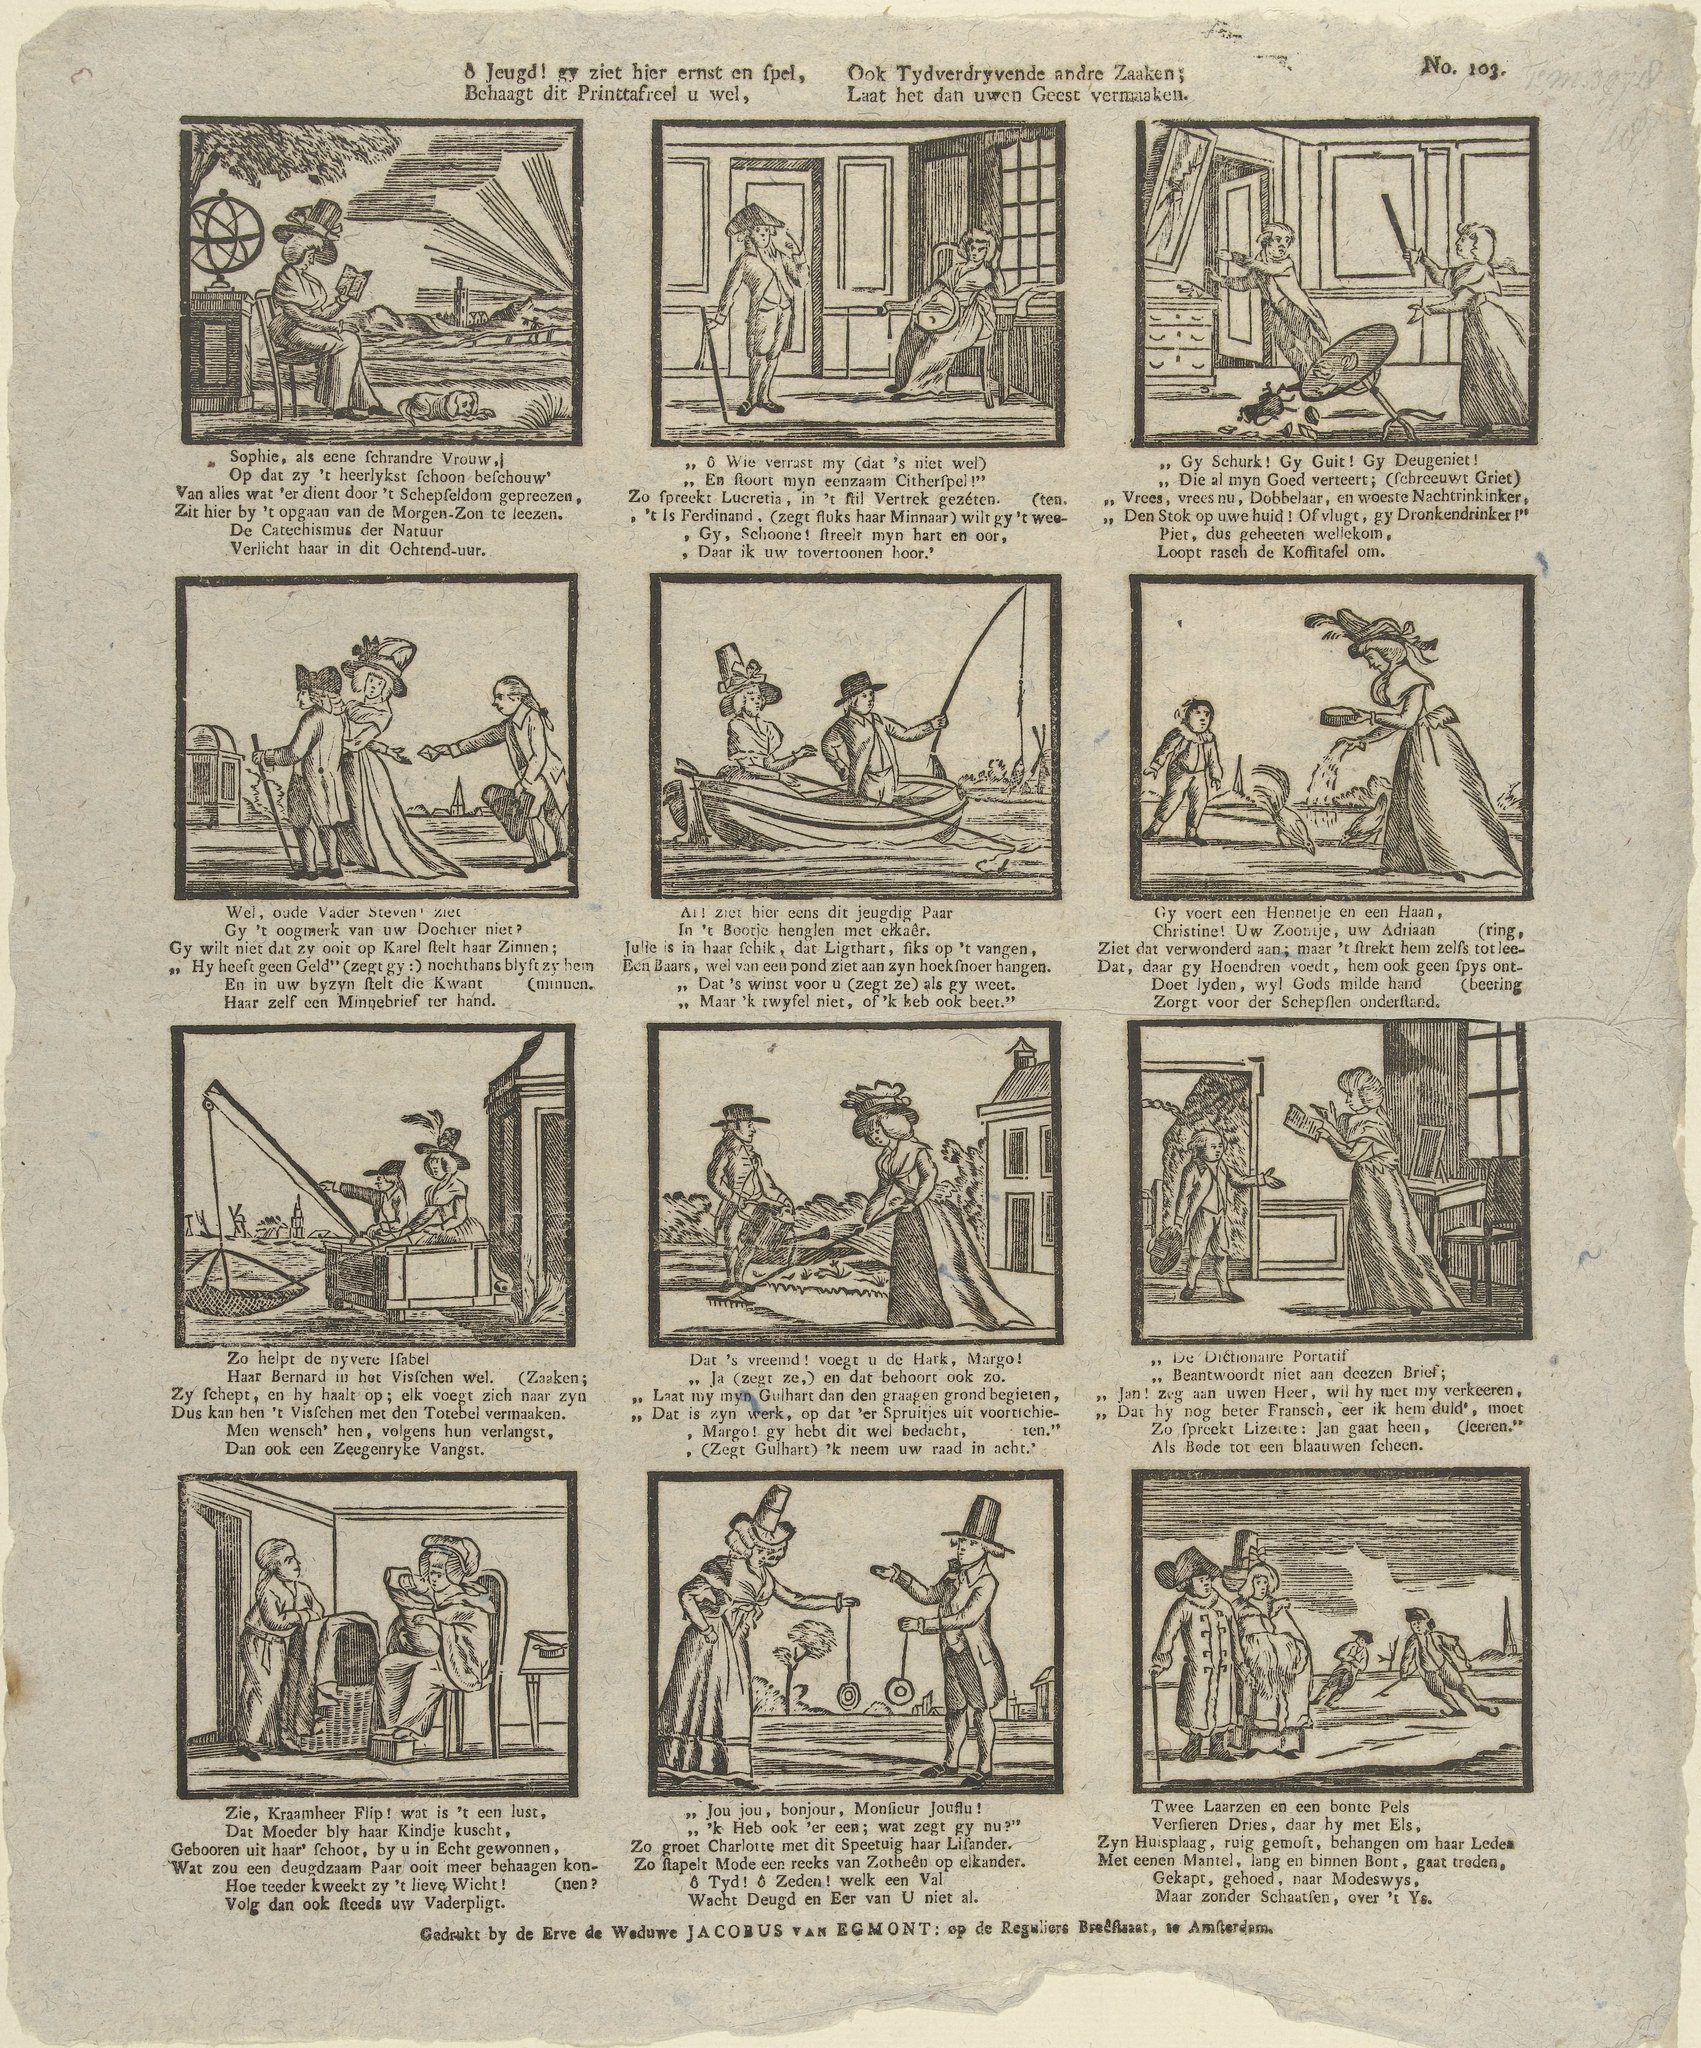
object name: print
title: O jeugd! gy ziet hier ernst en spel, / Behaagt dit printtafreel u wel, / Ook tydverdryvende andre zaaken; / Laat het dan uwen geest vermaaken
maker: Anonymous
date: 1761-1804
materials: paper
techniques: letterpress printing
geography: amsterdam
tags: children's games and plays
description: Blad met 12 voorstellingen van kinderspelen en bezigheden, waaronder lezen, vissen en schaatsen. Onder elke afbeelding een zesregelig vers. Genummerd rechtsboven: No. 103.